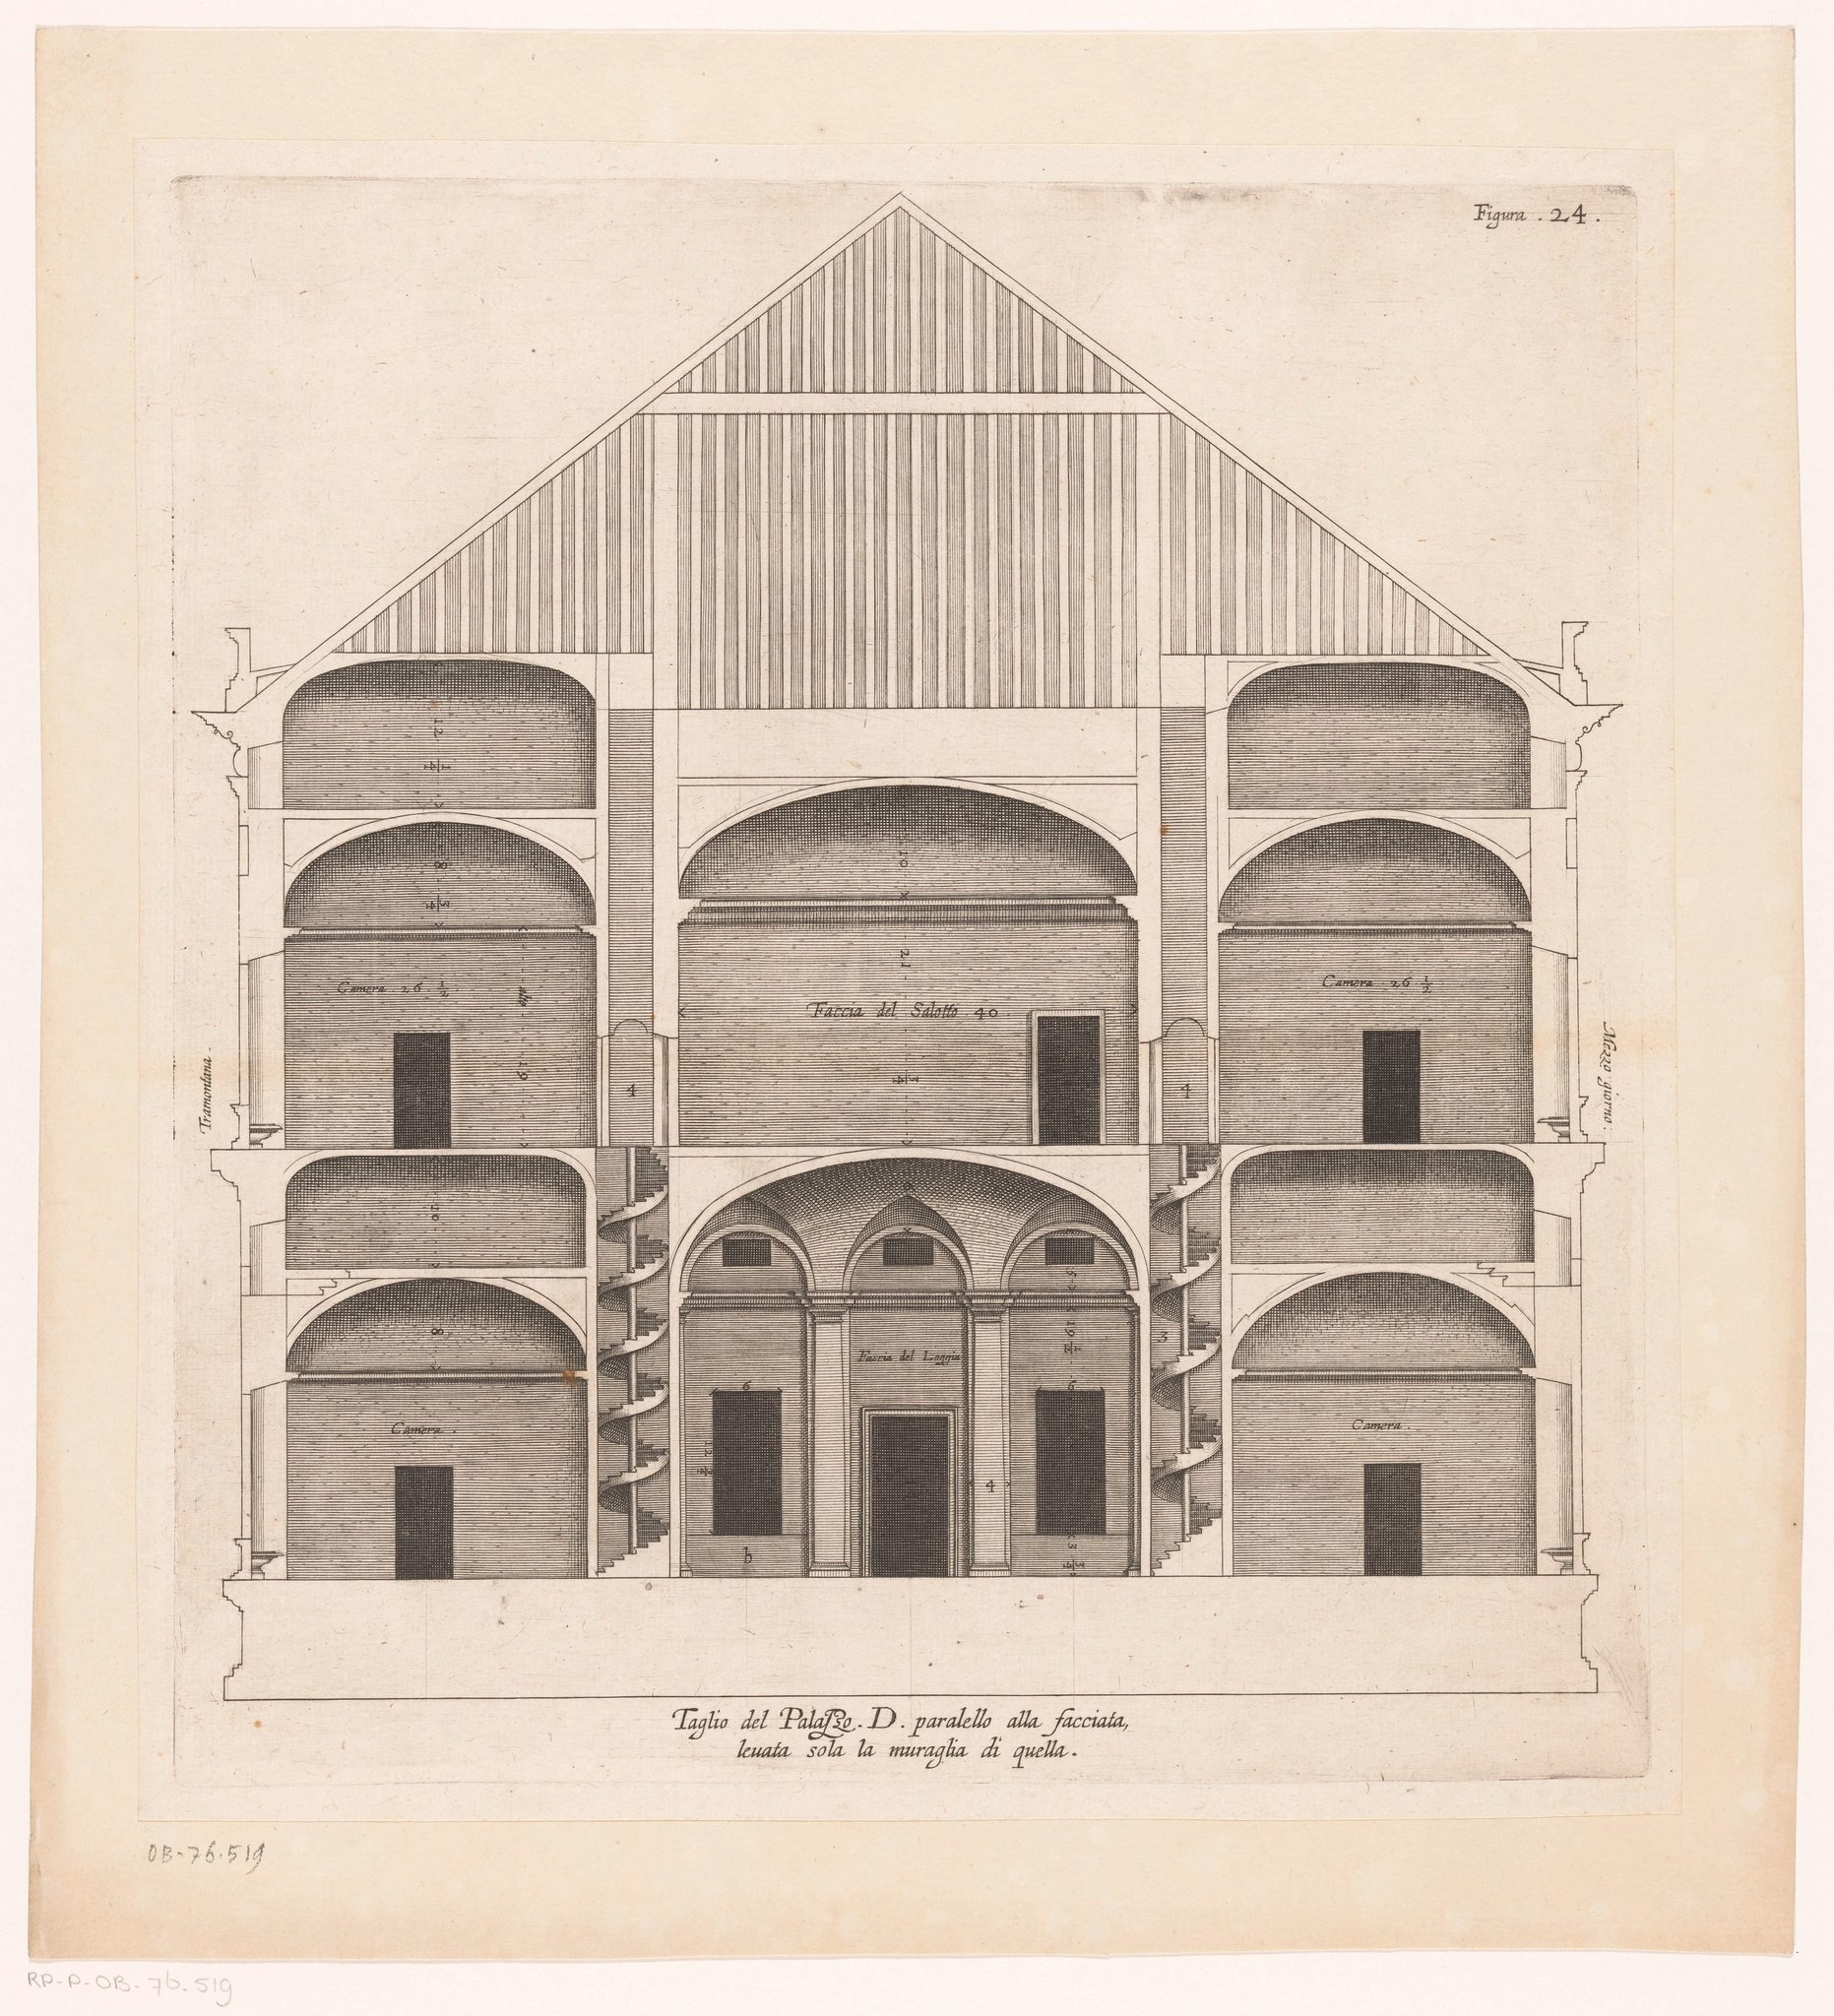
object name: ornament print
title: Dwarsdoorsnede van de Villa Grimaldi te Genua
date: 1622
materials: paper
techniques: engraving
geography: antwerp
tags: hôtel, i.e. small palace in city - aa - civic architecture: inside, section ~ architectural design or model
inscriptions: collector's mark: Lugt 240